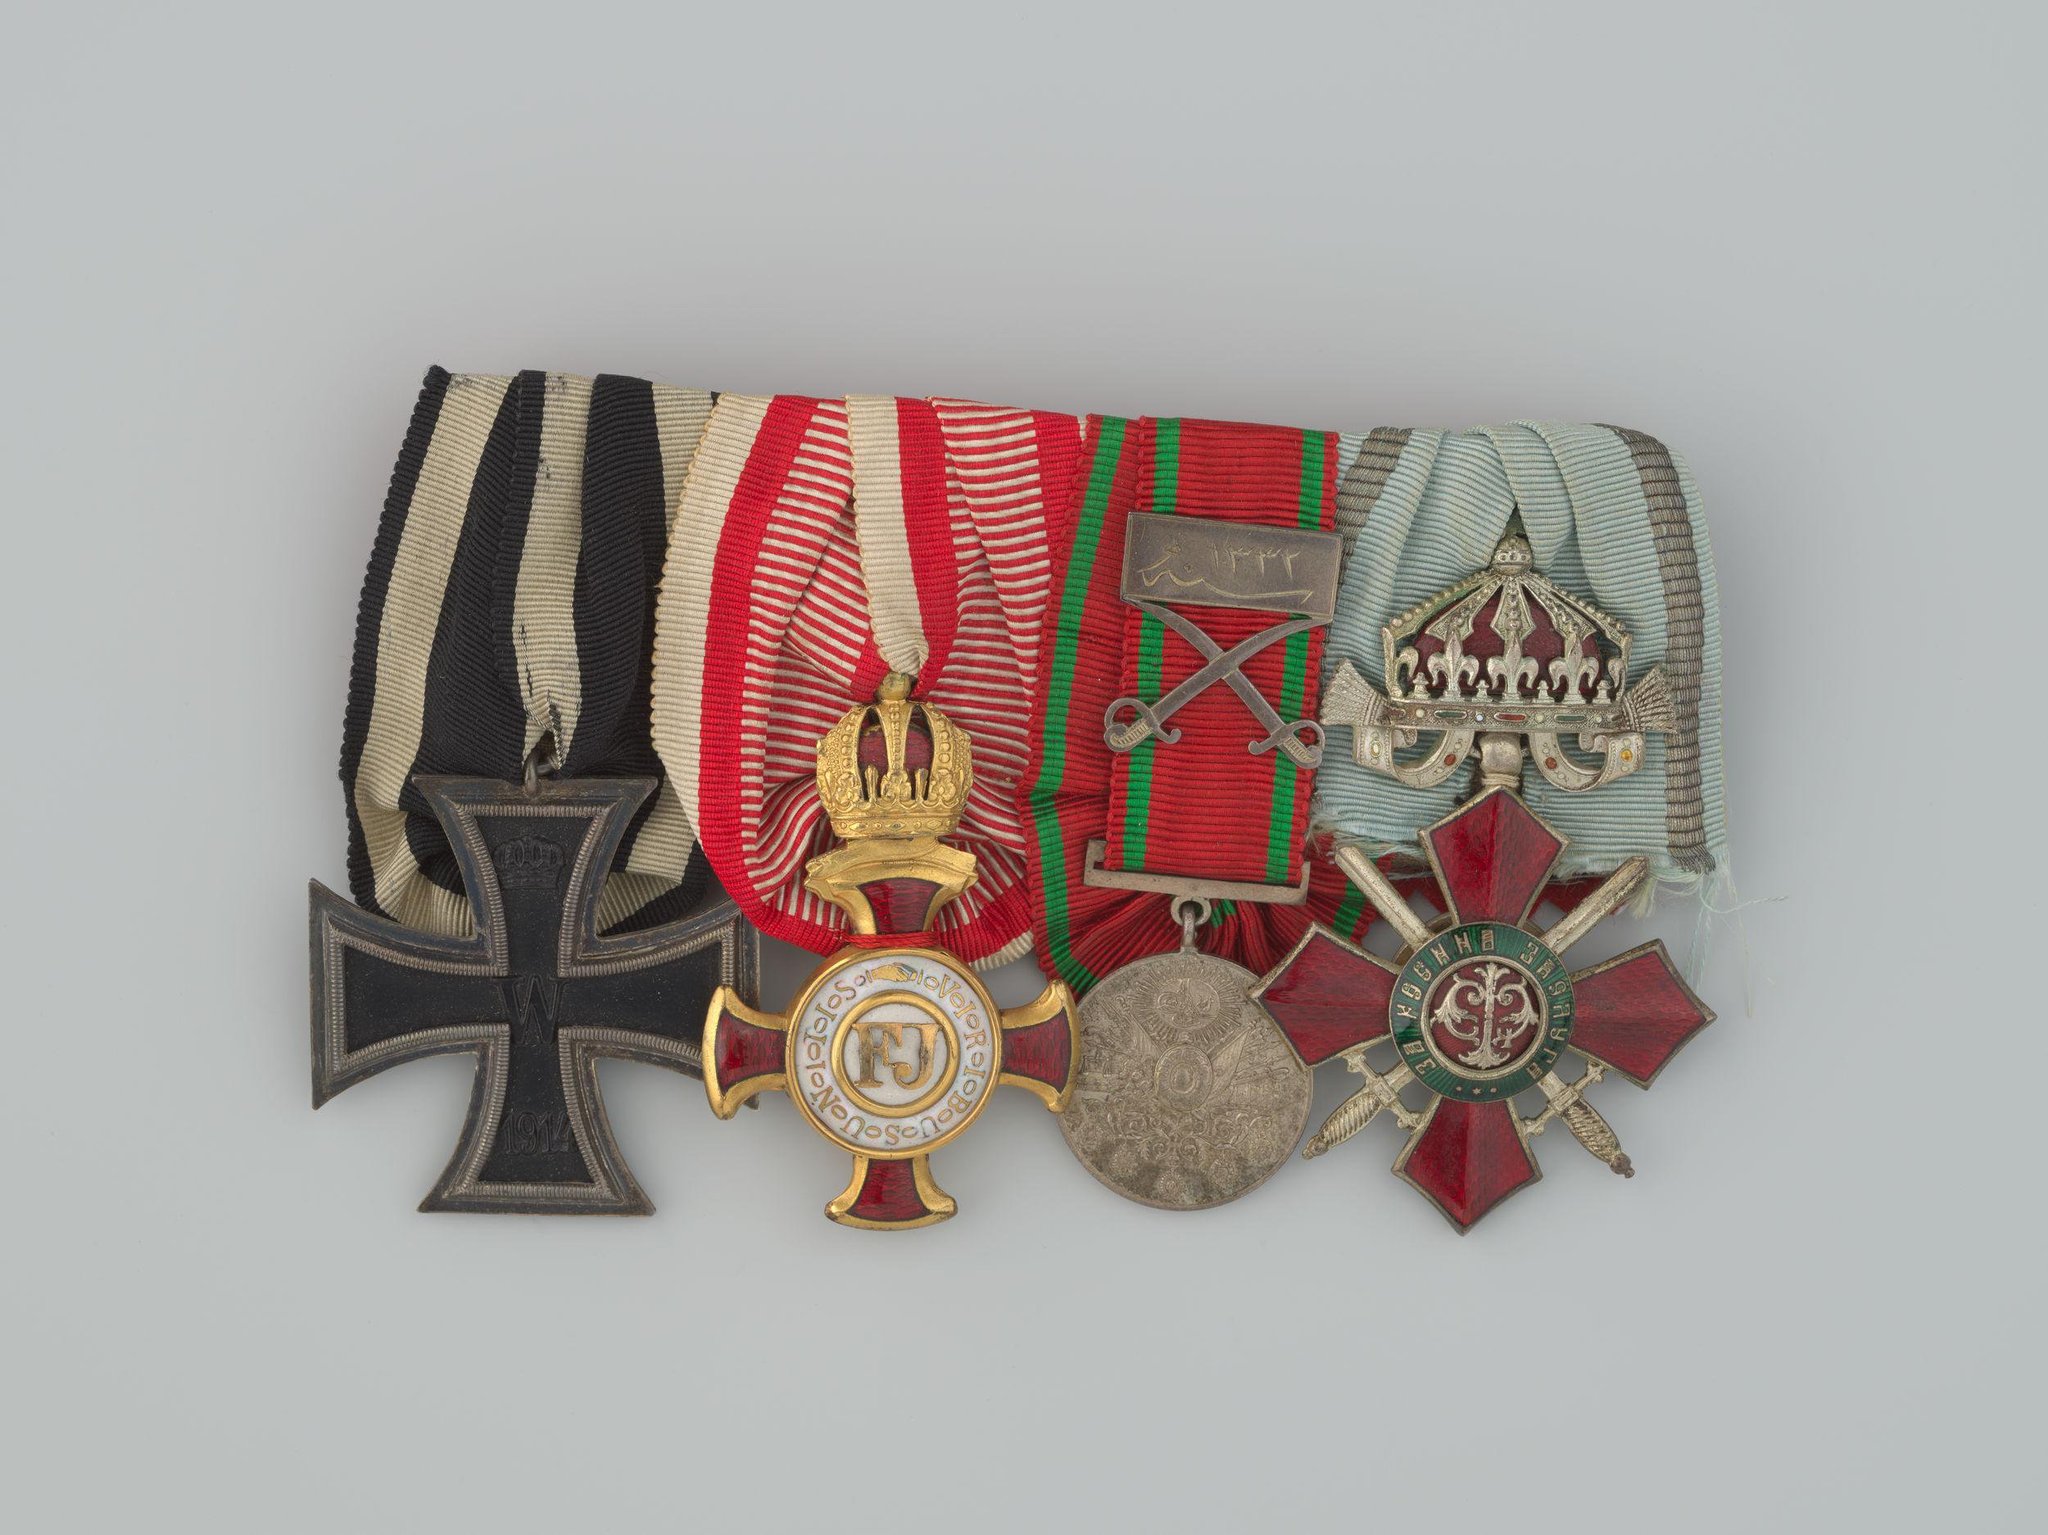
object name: onderscheidingsteken, onderscheiding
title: Kruis van verdienste (Oostenrijk)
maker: Anonymous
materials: silk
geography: austria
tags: eugen wachenheimer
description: Dit object is onderdeel van de nalatenschap van Isabel Elon-Wachenheimer (1928-2010). Tot haar overlijden behoorde het samen met de andere objecten uit de nalatenschap tot haar privédomein van Isabel Wachenheimer. In die particuliere context zijn deze objecten tezamen en individueel aandenkens - aan de jeugd, ouders en familie van Isabel Wachenheimer vóór en tijdens de Shoah en aan haar leven na de Tweede Wereldoorlog. Isabel Wachenheimer, die van juni 1943 tot mei 1945 gevangen zat in Kamp Westerbork, Theresienstadt, Auschwitz, Lenzing a/d Oberdonau (een buitenkamp van Mauthausen), overleefde de Shoah. Haar ouders – Eugène Wachenheimer en Else Wachenheimer-Moos - werden op 14 oktober 1944 in Auschwitz-Birkenau vermoord.